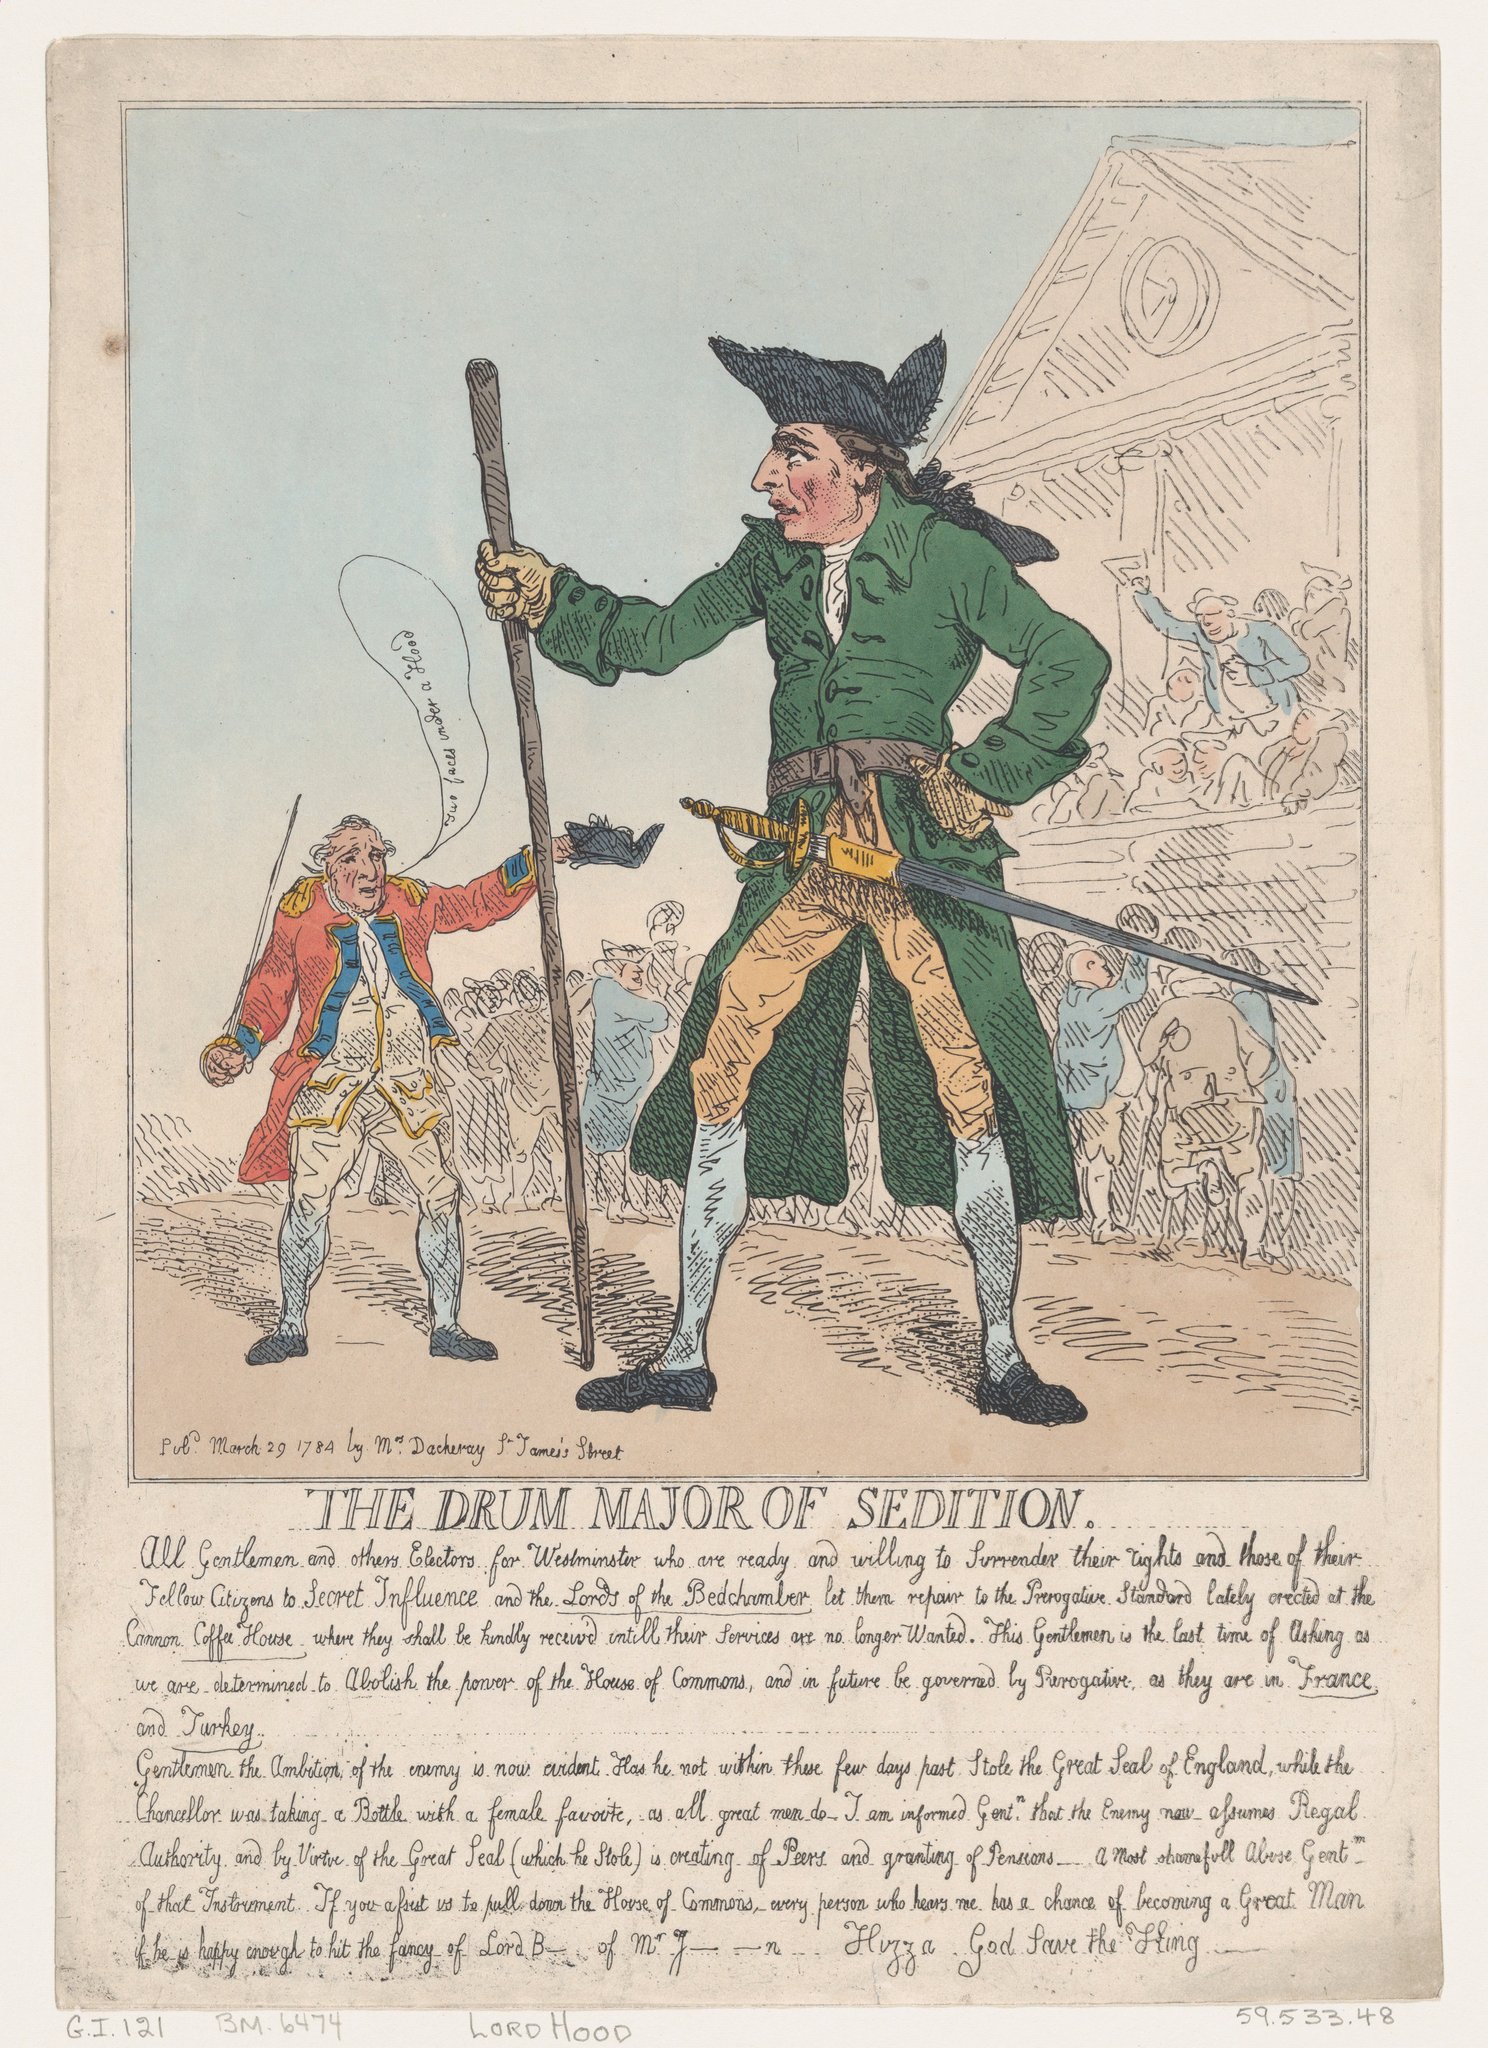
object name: print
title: The Drum Major of Sedition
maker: thomas rowlandson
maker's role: artist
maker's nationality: british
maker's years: 1757-1827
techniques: etching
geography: london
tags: men,crowd